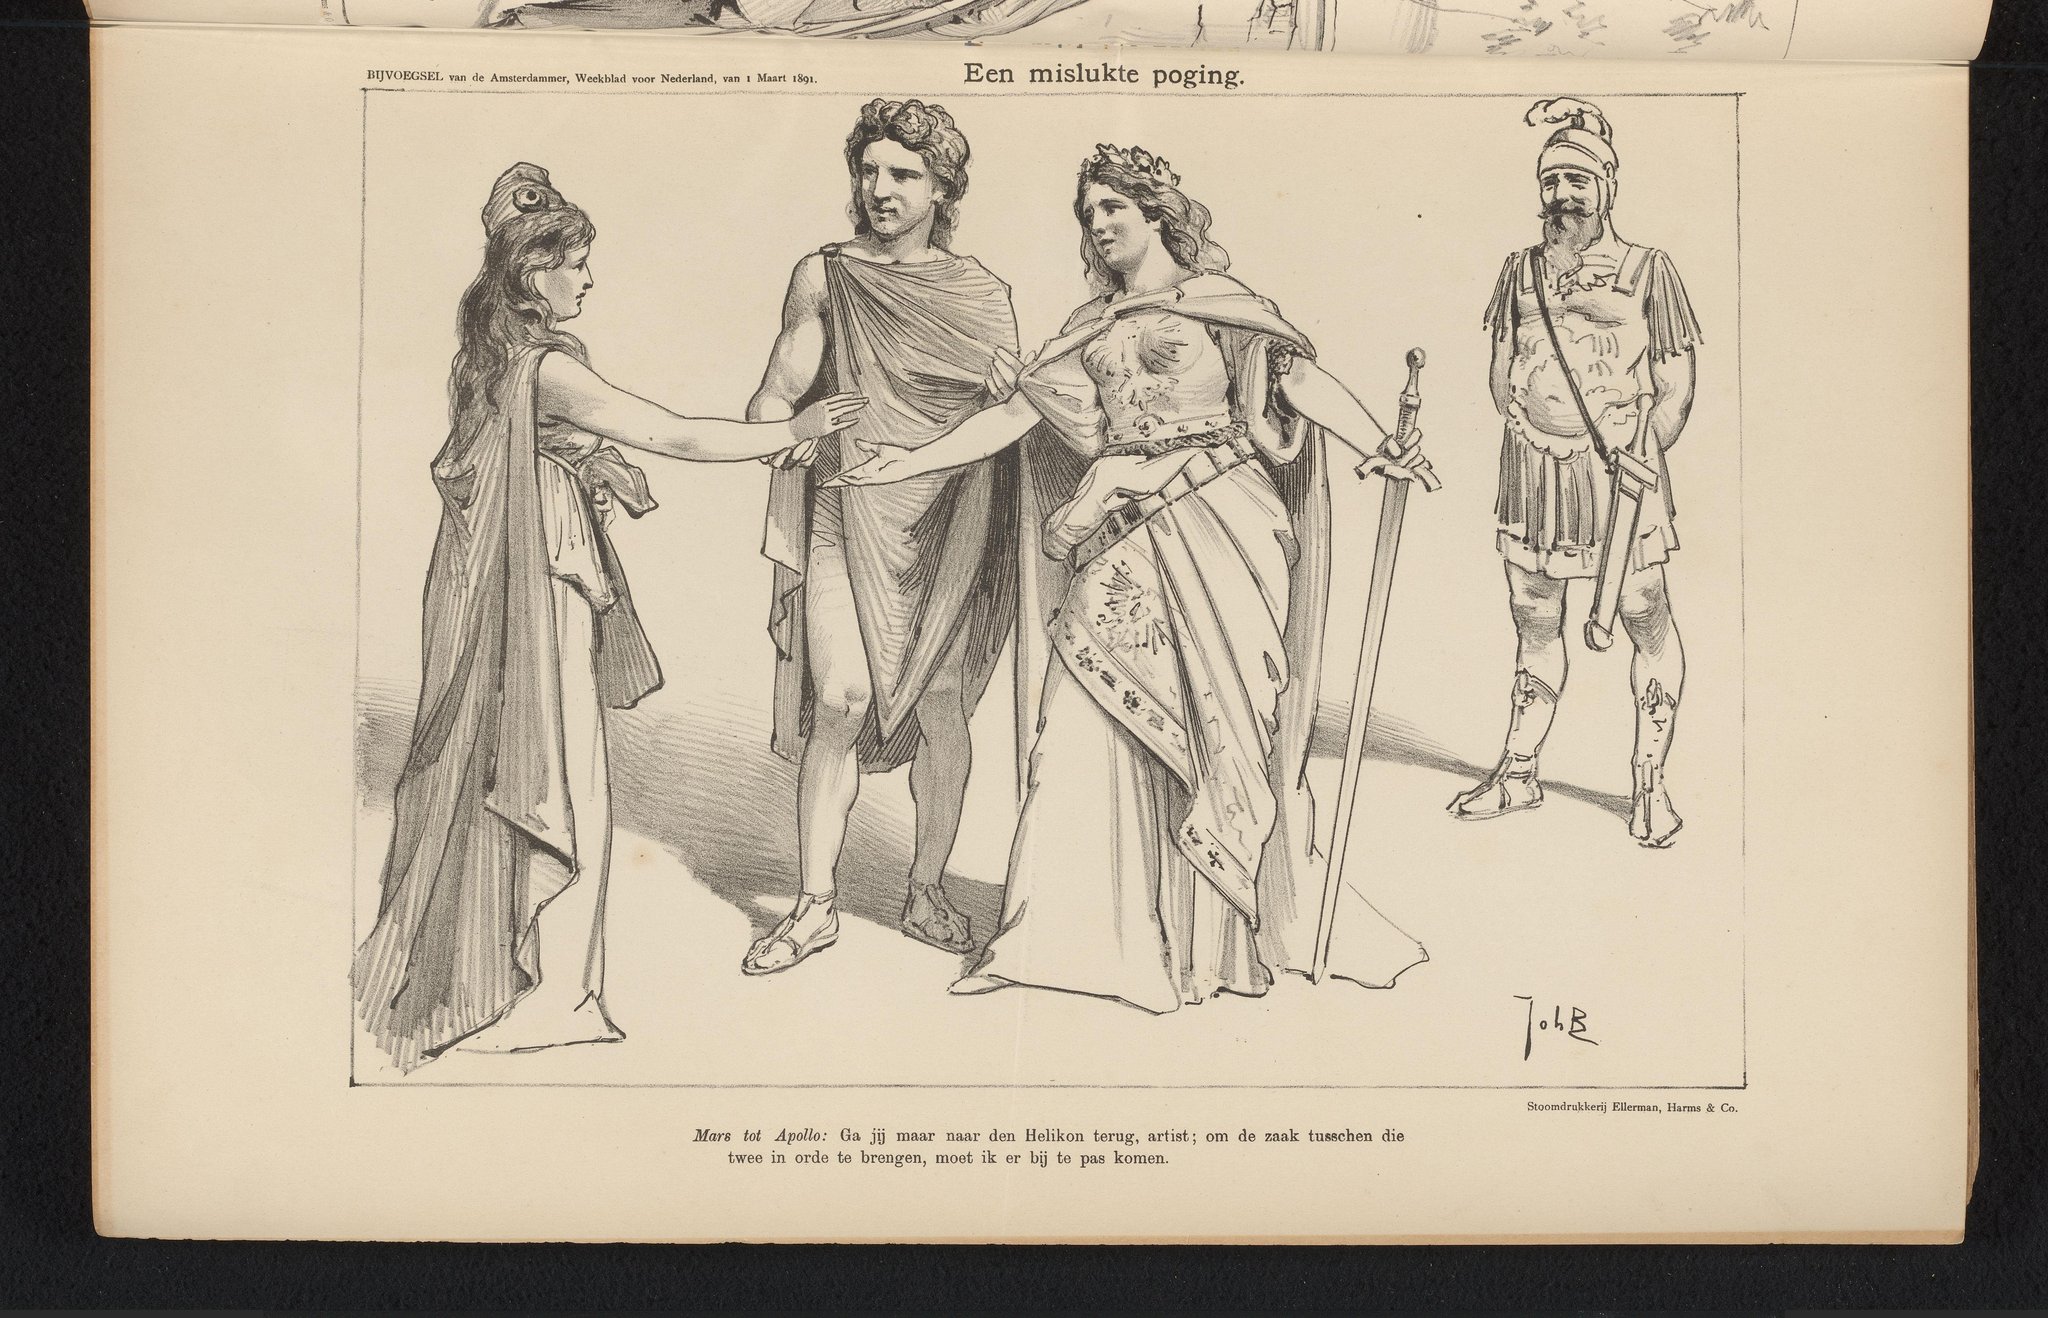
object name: cartoon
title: Een mislukte poging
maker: johan braakensiek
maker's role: draughtsman, print maker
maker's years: 1858-1940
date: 1891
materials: paper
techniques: lithograph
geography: amsterdam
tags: symbols, allegories of peace, 'pax'; 'pace' (ripa), personifications of countries, nations, states, districts, etc. (+ nation; national), political caricatures and satires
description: De oorlogsgod Mars stuurt Apollo terug naar de Helicon na een mislukte poging tot verzoening tussen de Marianne (Frankrijk) en Germania (Duitsland).